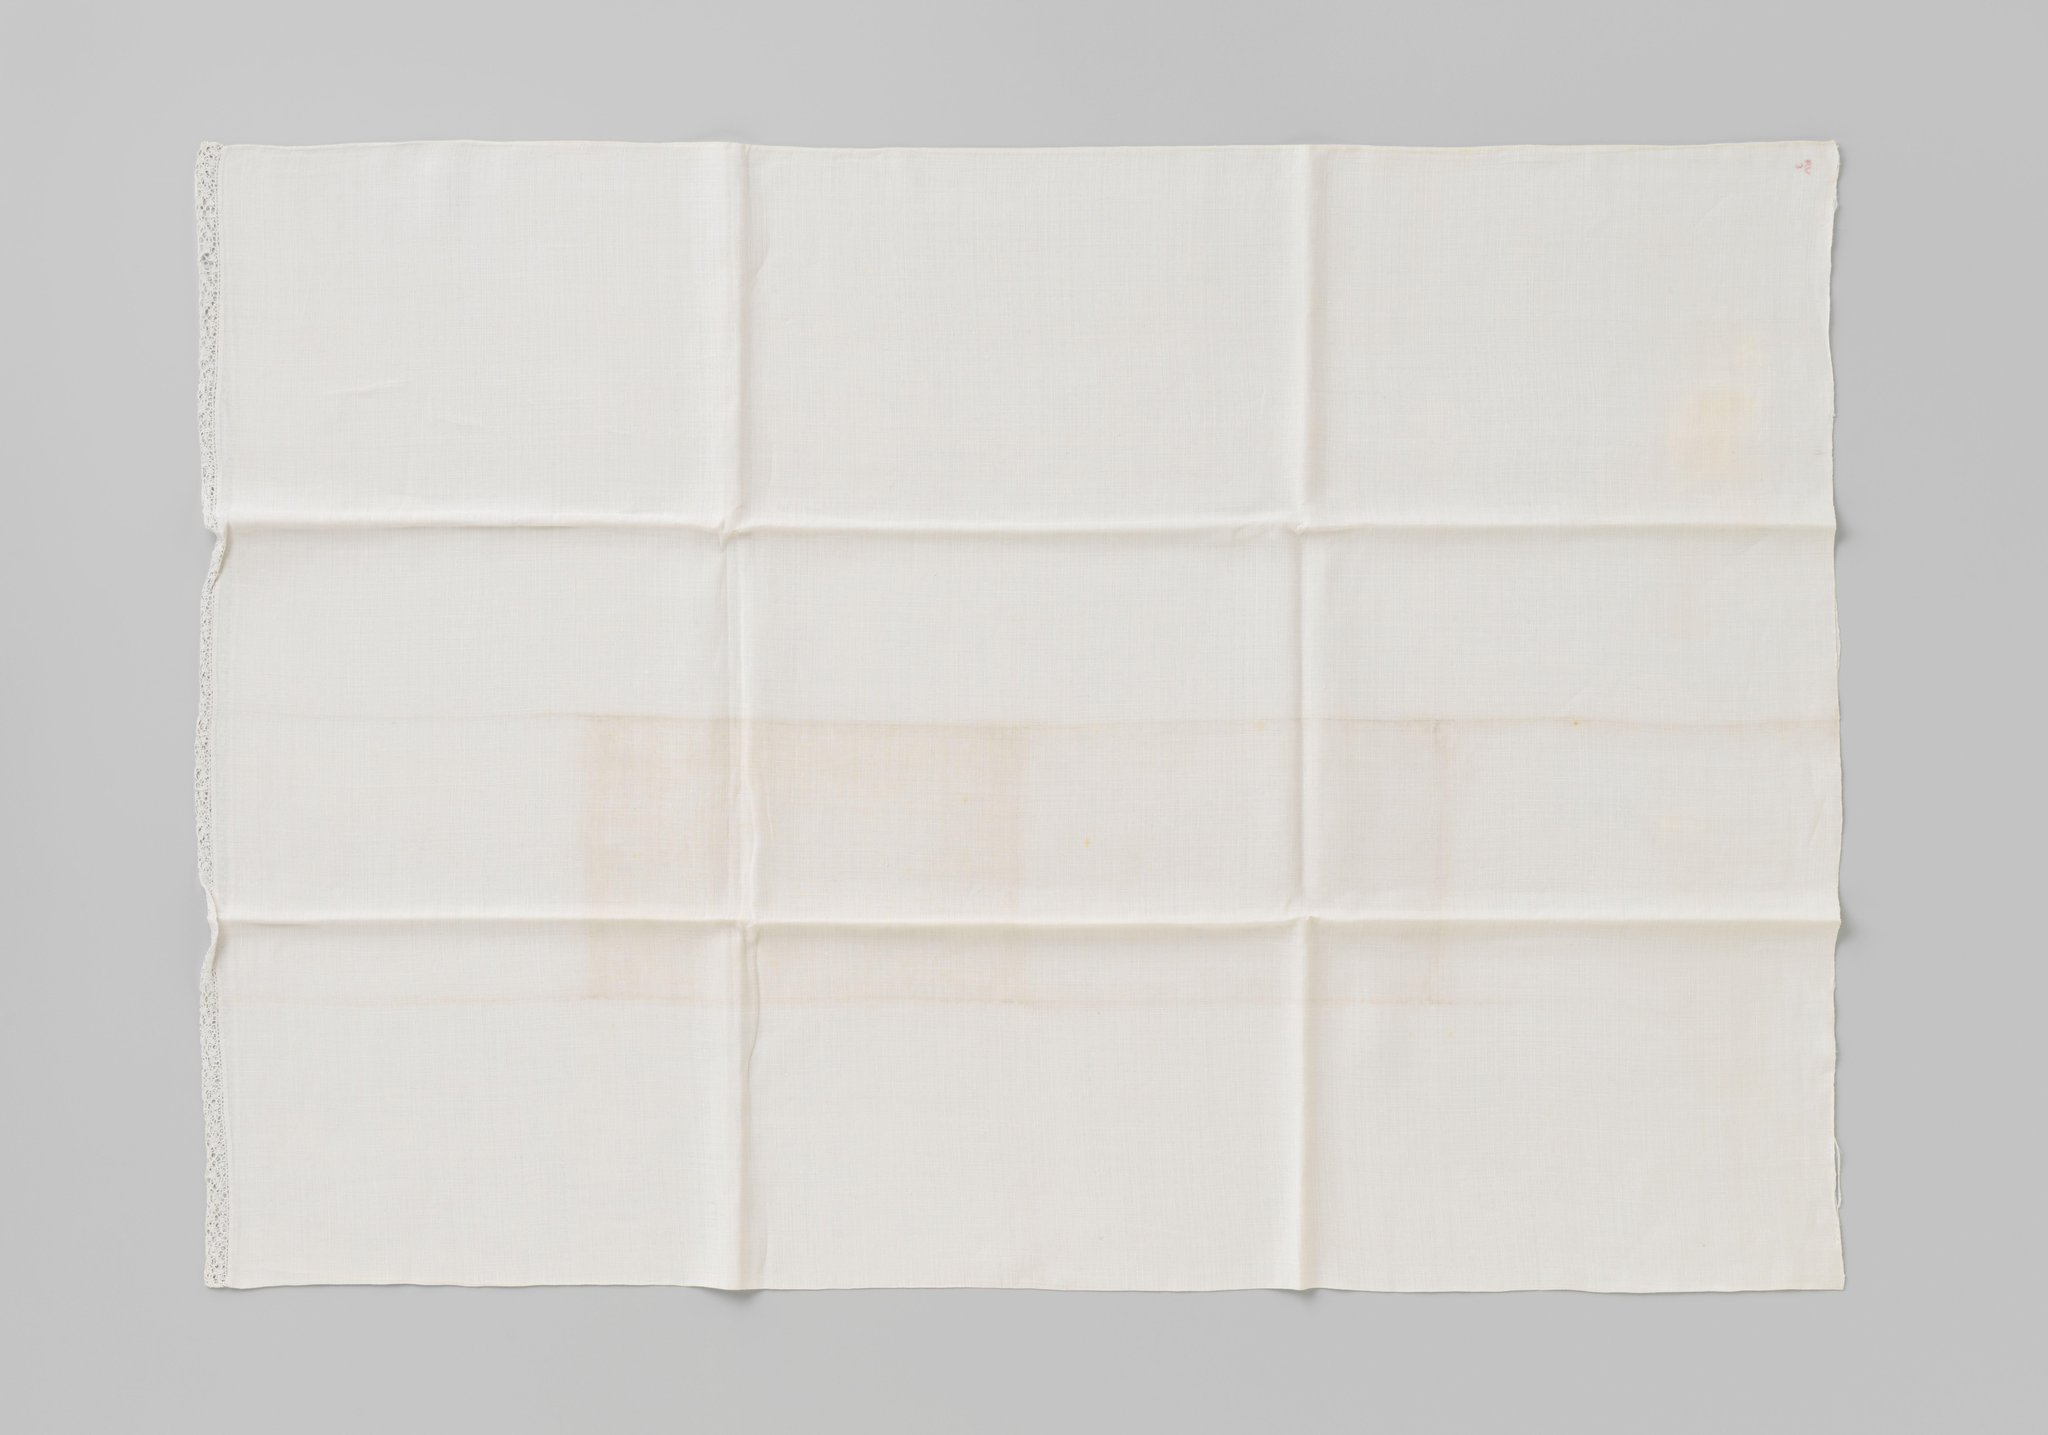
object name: sloop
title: Sloop van linnen met tussenzetsel van kloskant en gemerkt in rode kruissteek RV3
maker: Anonymous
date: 1650-1674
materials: linen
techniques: lace, cross stitching, weave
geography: northern netherlands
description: Sloop van naturelkleurig linnen met een tussenzetsel van kloskant: oudvlaamse kloskant met vlechtengrond. De sloop is gemerkt in rode kruissteek: RV 3 (v.d.Ven).